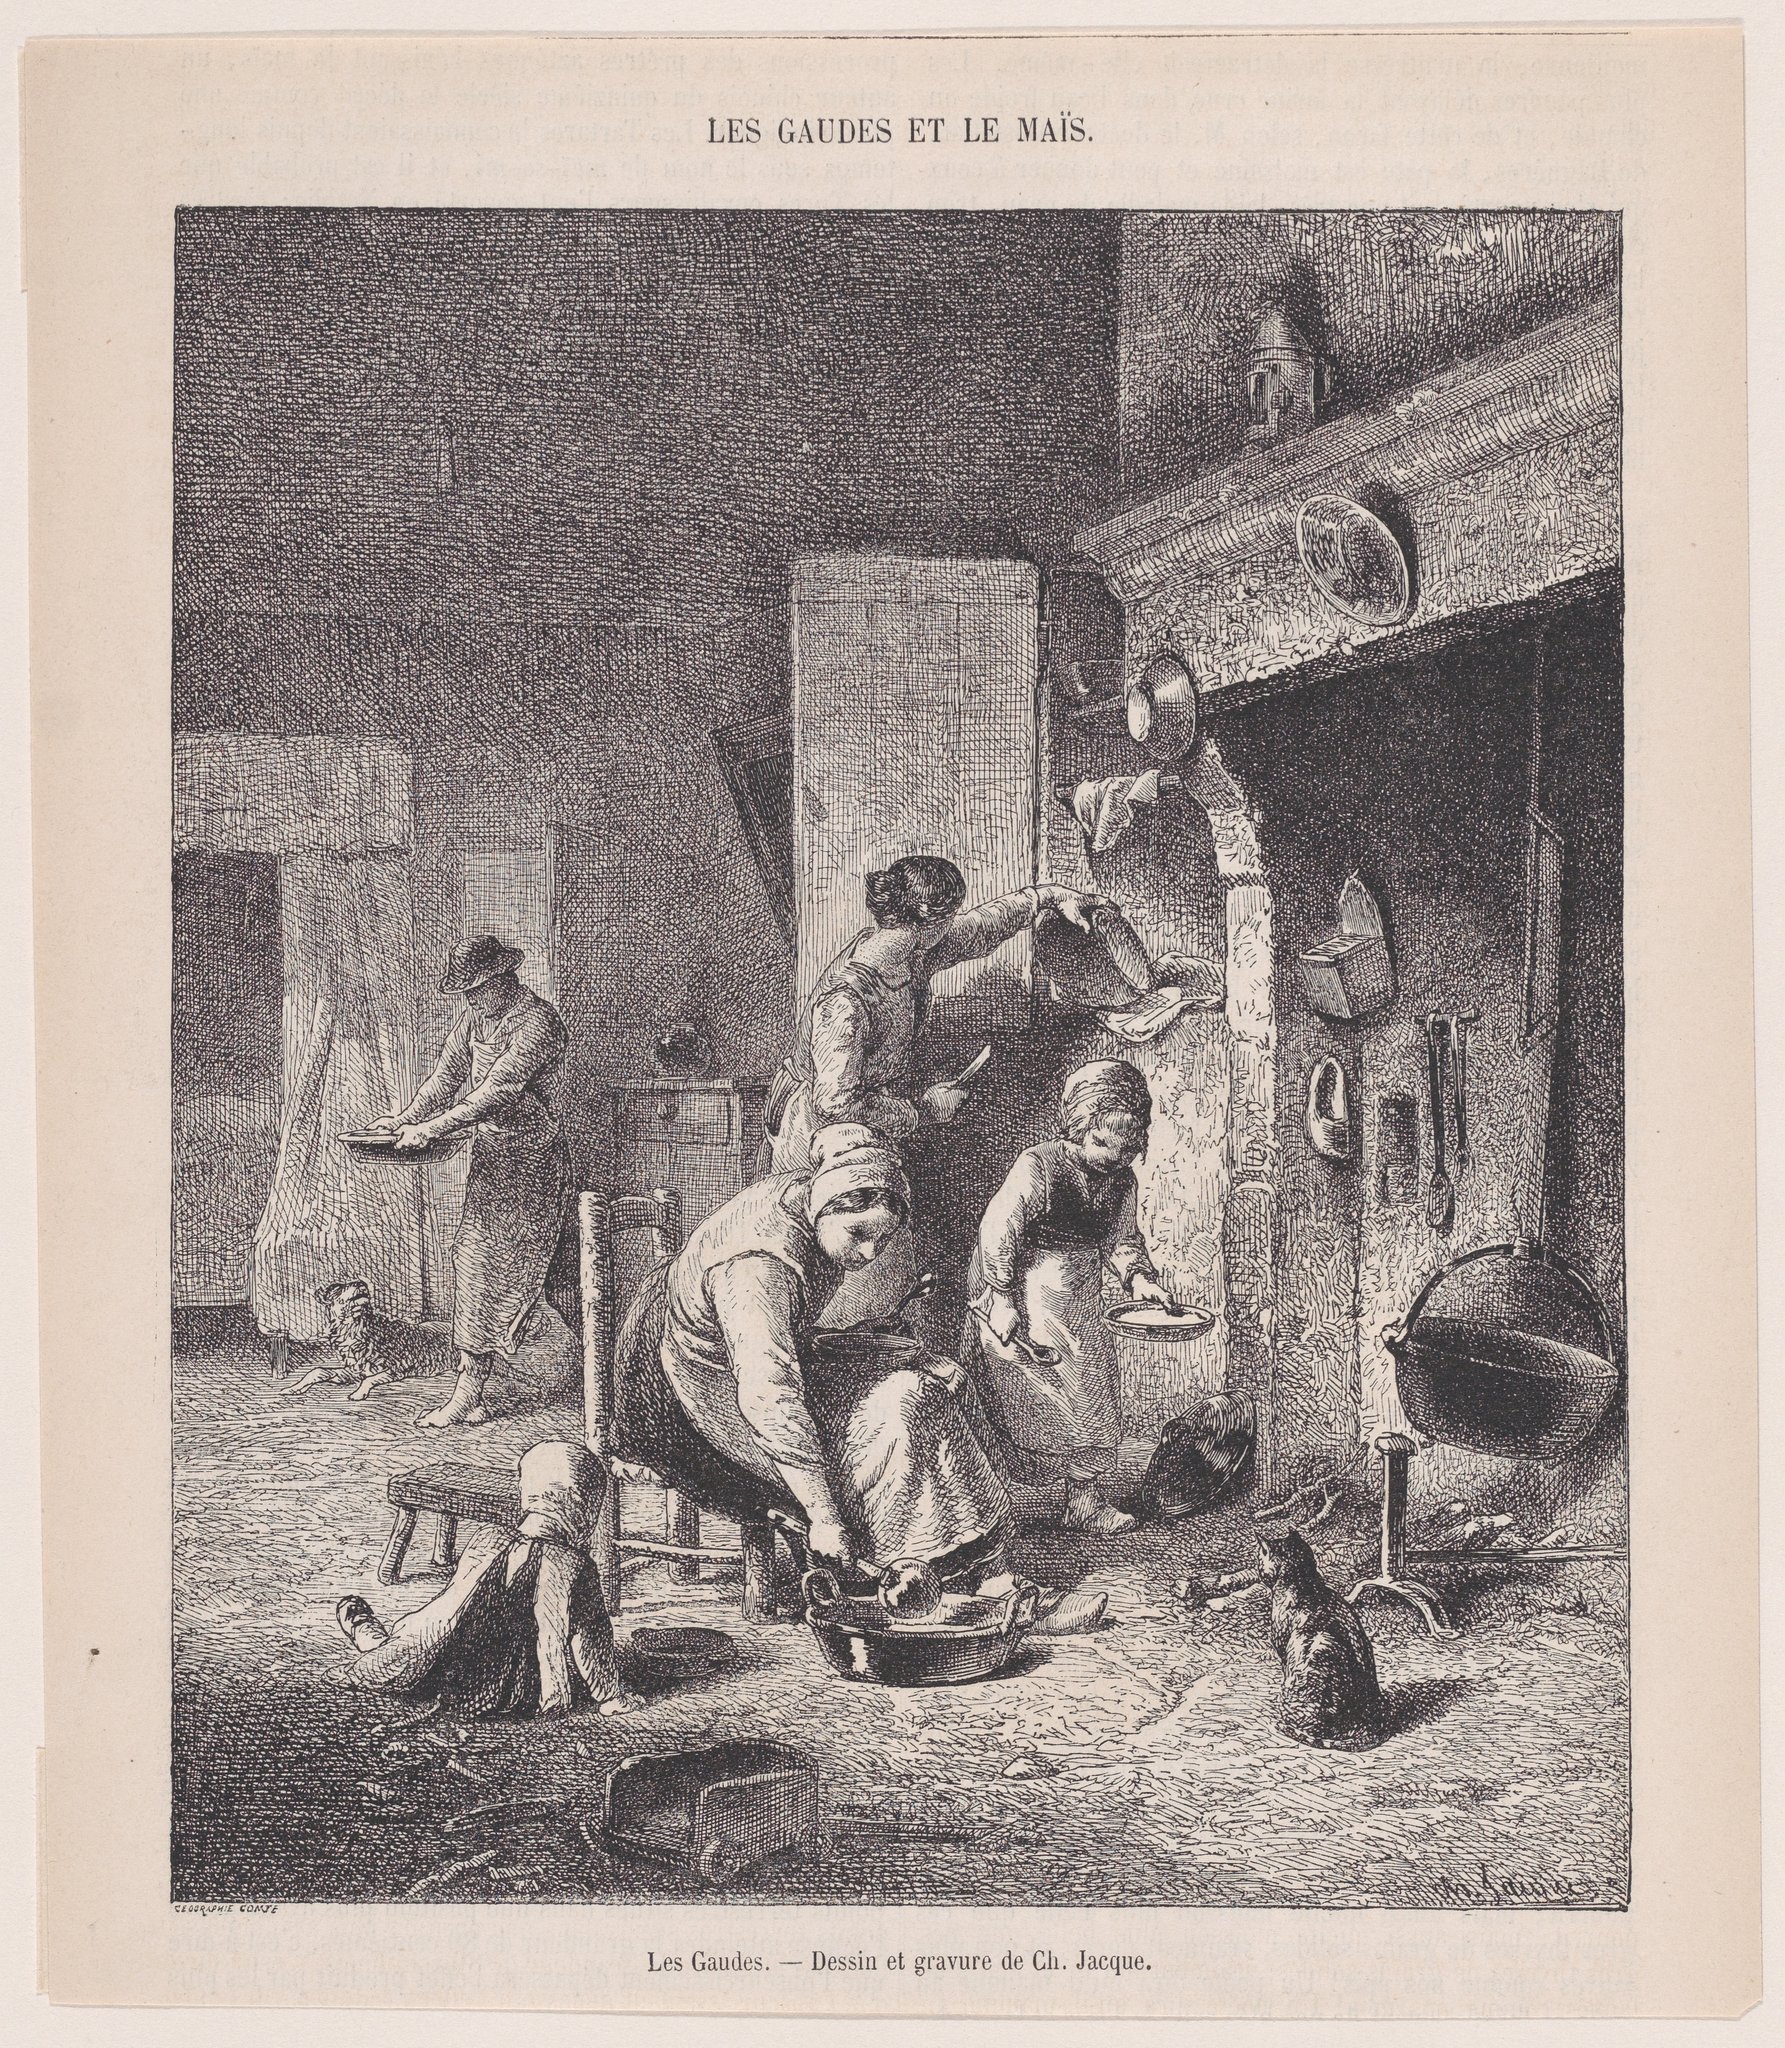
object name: print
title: Gruel, from "Le Magasin Pittoresque"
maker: charles émile jacque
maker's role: artist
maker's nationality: french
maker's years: 1813-1894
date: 1852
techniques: relief print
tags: food,interiors,children,men,women,cats